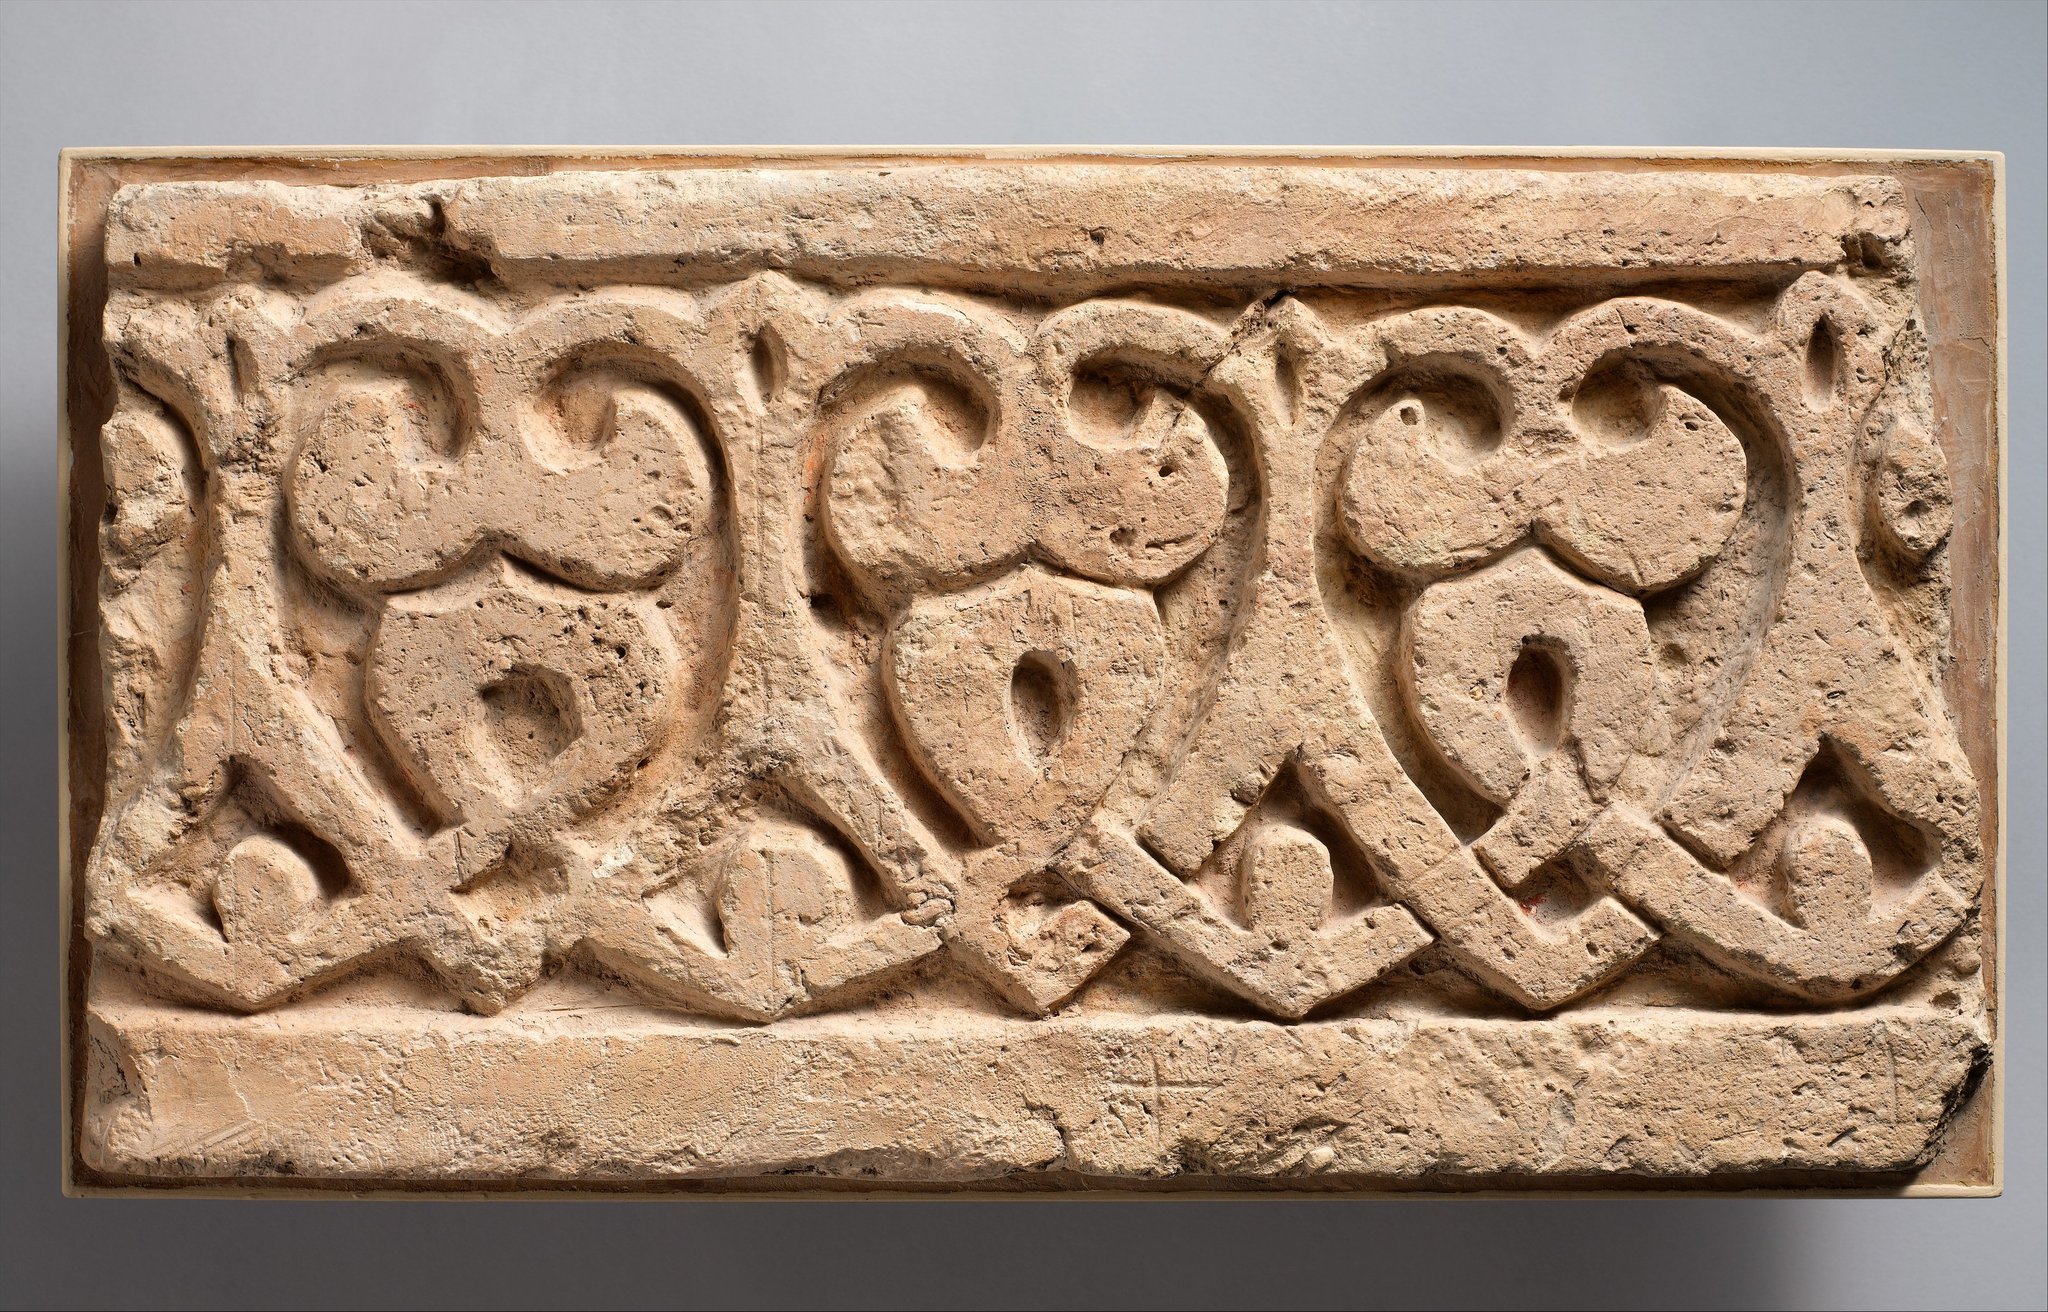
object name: frieze fragment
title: Fragment of a Frieze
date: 1001-1100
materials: terracotta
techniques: carving, painting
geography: iran